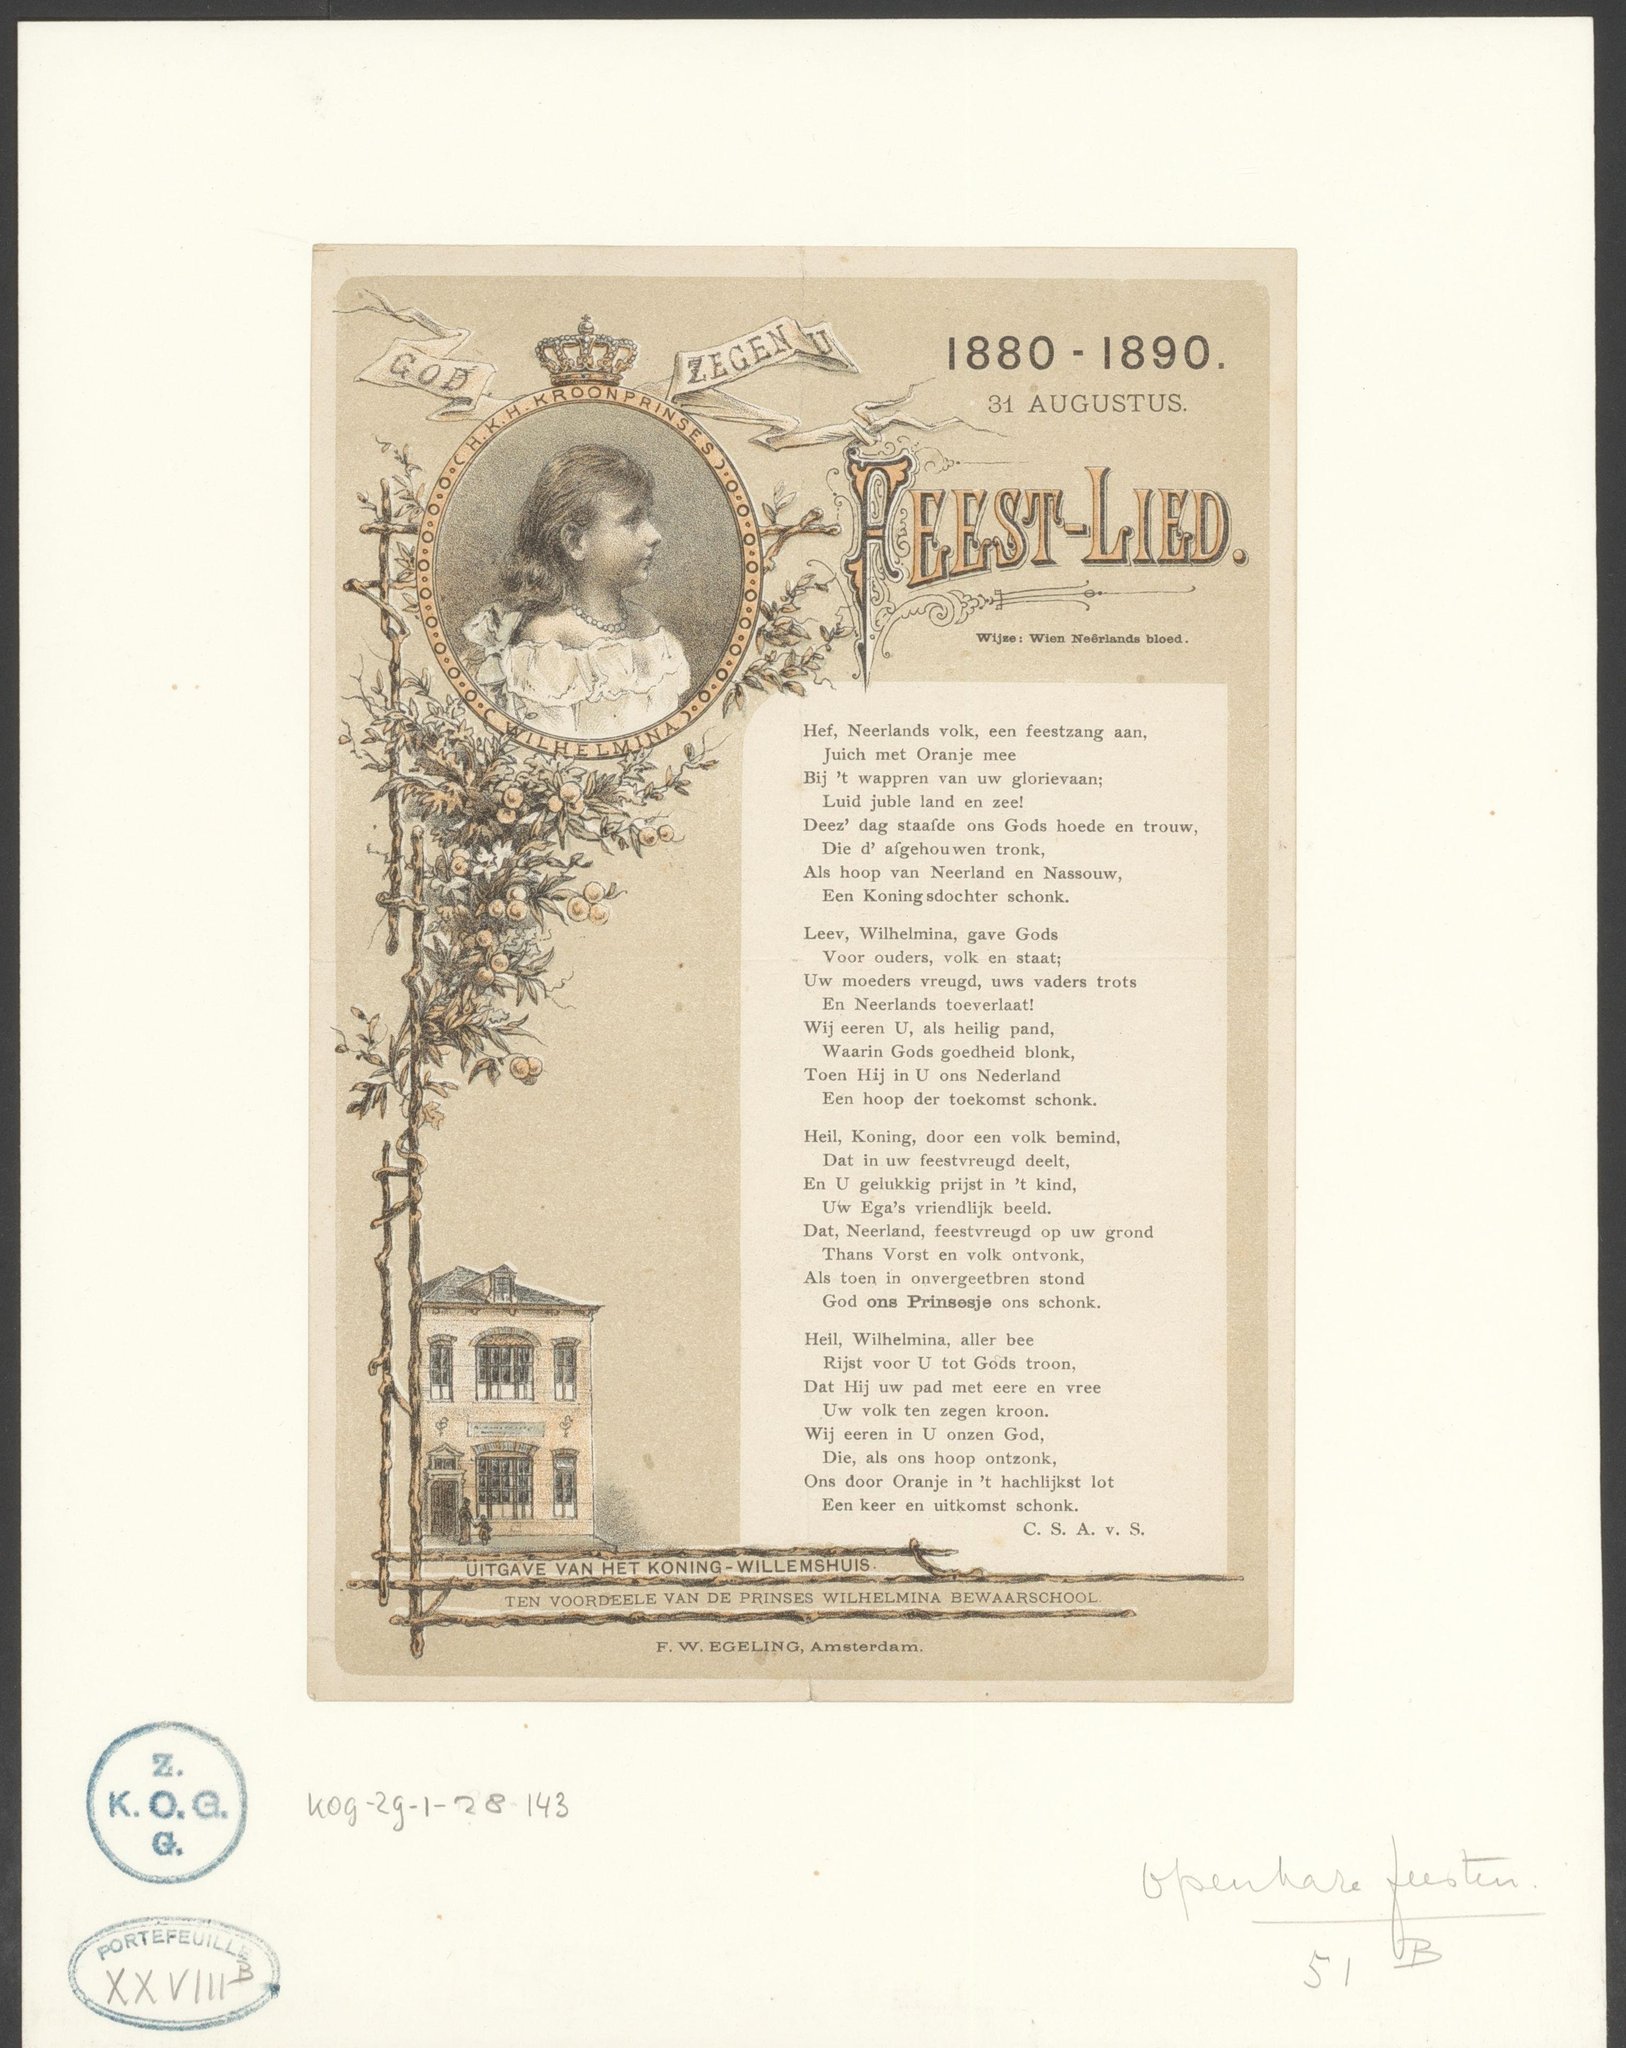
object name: print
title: Lied ter gelegenheid van de tiende verjaardag van Wilhelmina, later koningin der Nederlanden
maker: Anonymous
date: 1890-1892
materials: paper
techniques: tone lithography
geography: amsterdam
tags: the hague, print maker, wilhelmina of the netherlands, historical persons - bb - woman, elementary school; class, form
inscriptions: collector's mark: Lugt 1641, stamp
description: Lied ter gelegenheid van de tiende verjaardag van Wilhelmina, later koningin der Nederlanden. Gezongen voor de Prinses Wilhelmina Bewaarschool. Onderwerpsrubrieken binnen de Atlas Zeden en Gewoonten: Zeden en Gewoonten in Engeren Zin. Volksleven. Openbare feesten. Vorstelijke intochten, (Illuminaties, vuurwerken en dergelijke, openbare feesten).